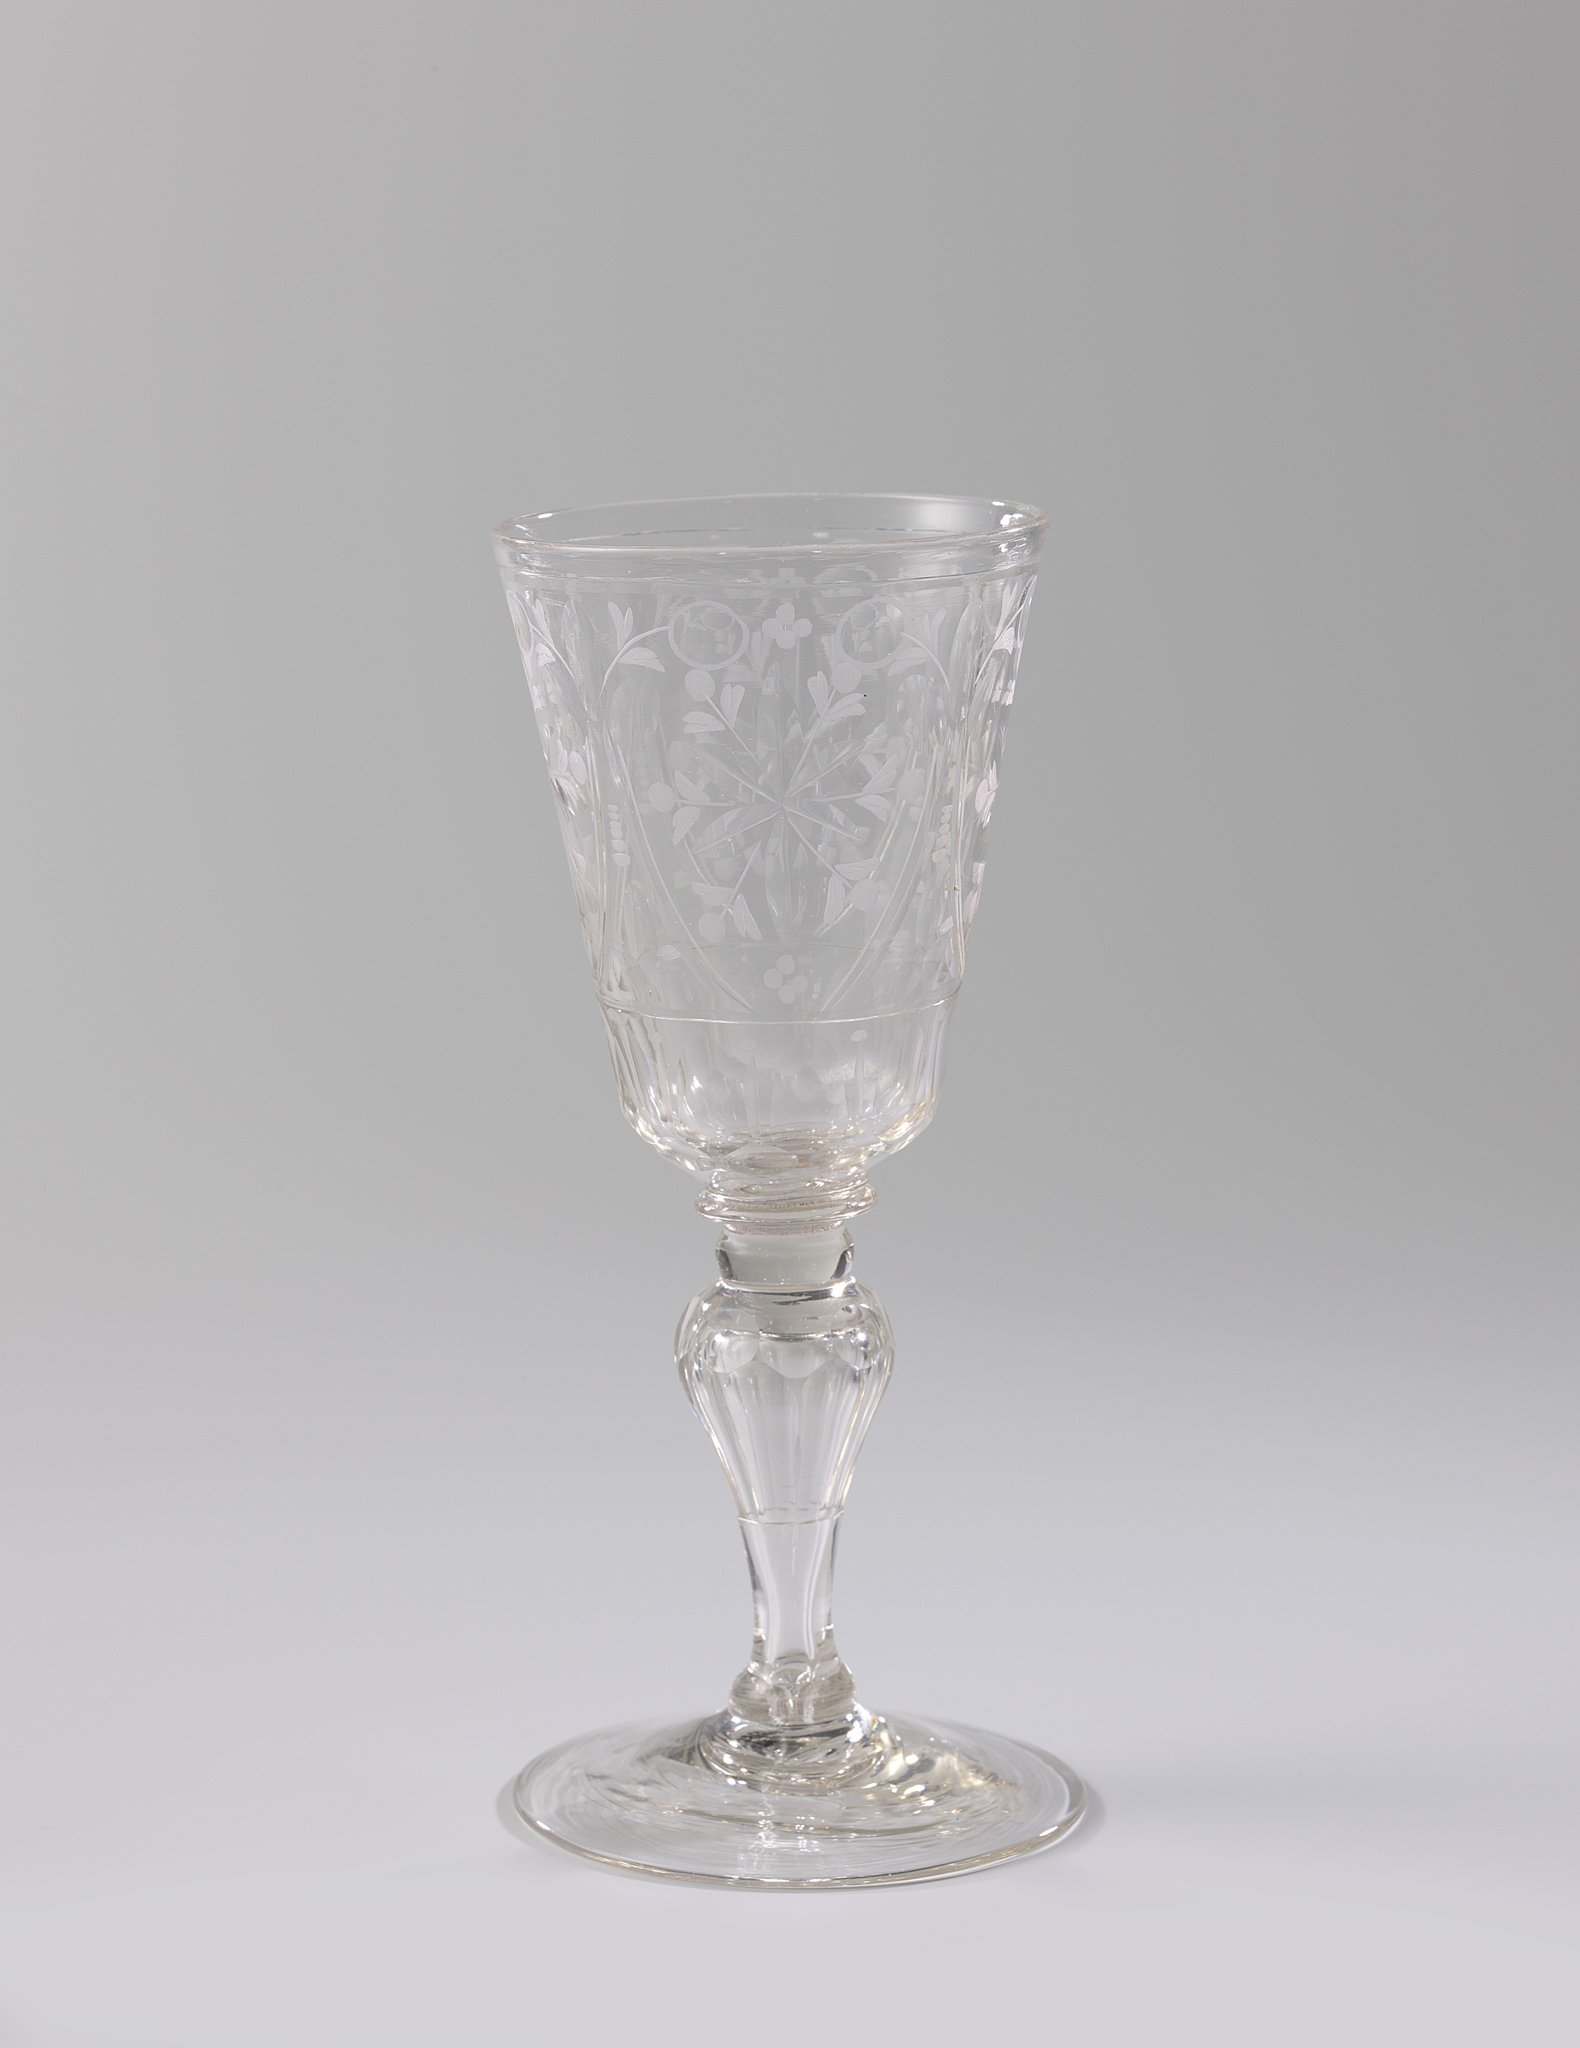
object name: goblet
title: Bokaal met hartvormige uitsparingen met sterren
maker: Anonymous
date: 1725-1750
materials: glass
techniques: glassblowing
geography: bohemia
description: Conische voet. Holle gefacetteerde, balustervormige stam met twee knopen en een samengestelde schijf. Trechtervormige kelk met gefacetteerde, afgeronde bodem. Op de kelk vier hartvormige uitsparingen met geslepen sterren. Tussen de punten van de sterren ranken met bessen. De uitsparingen worden bekroond met twijgen.